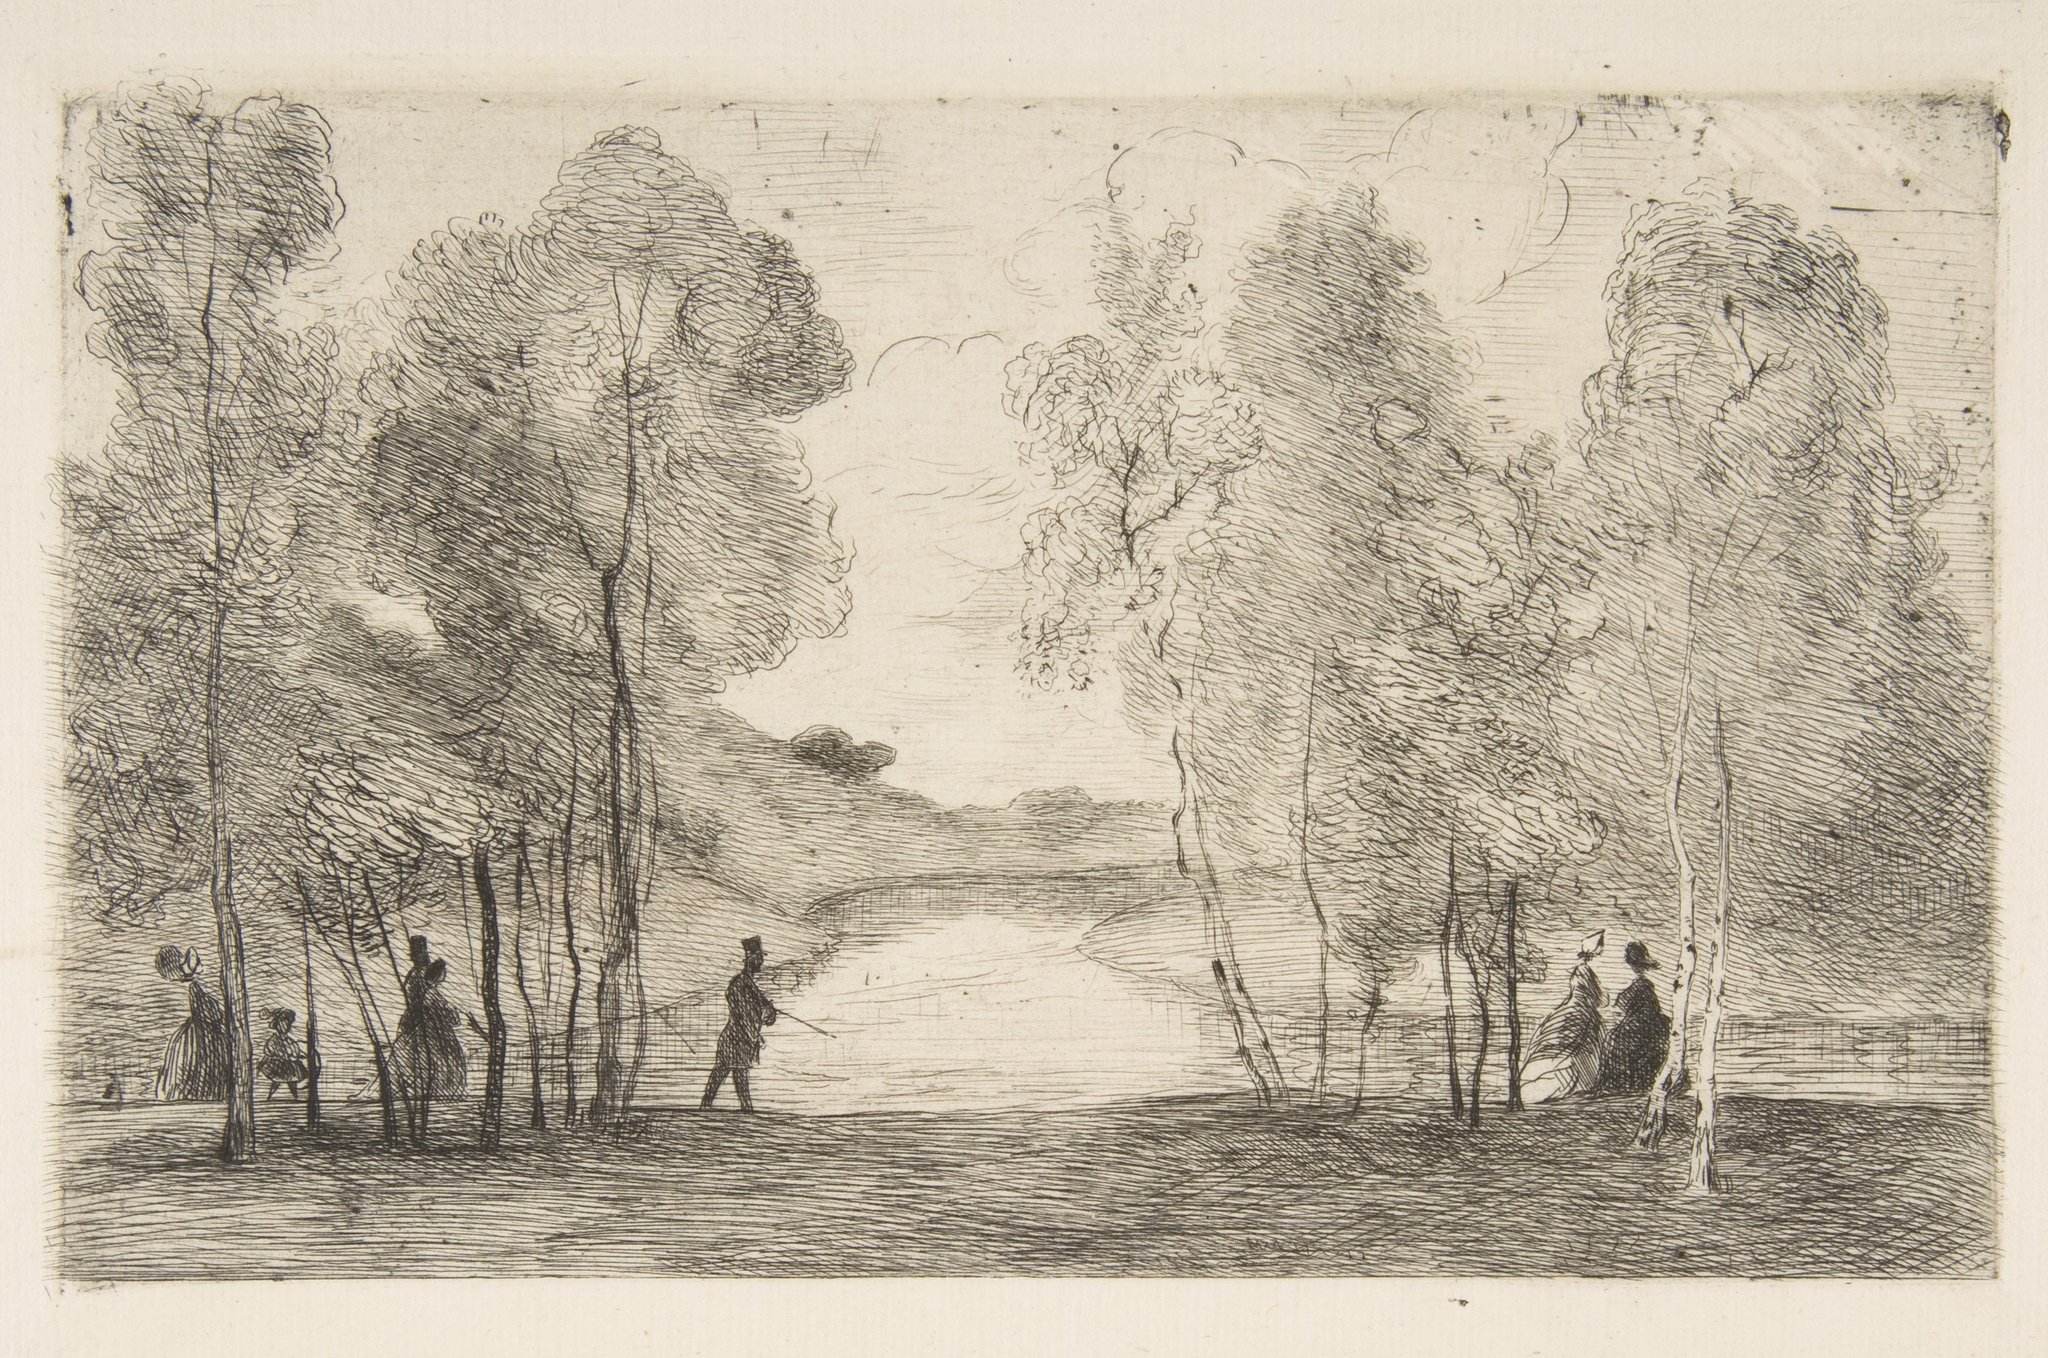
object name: print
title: La lac du Bois de Boulogne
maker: félix bracquemond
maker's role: artist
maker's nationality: french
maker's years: 1833-1914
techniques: etching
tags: human figures,roads,landscapes,trees